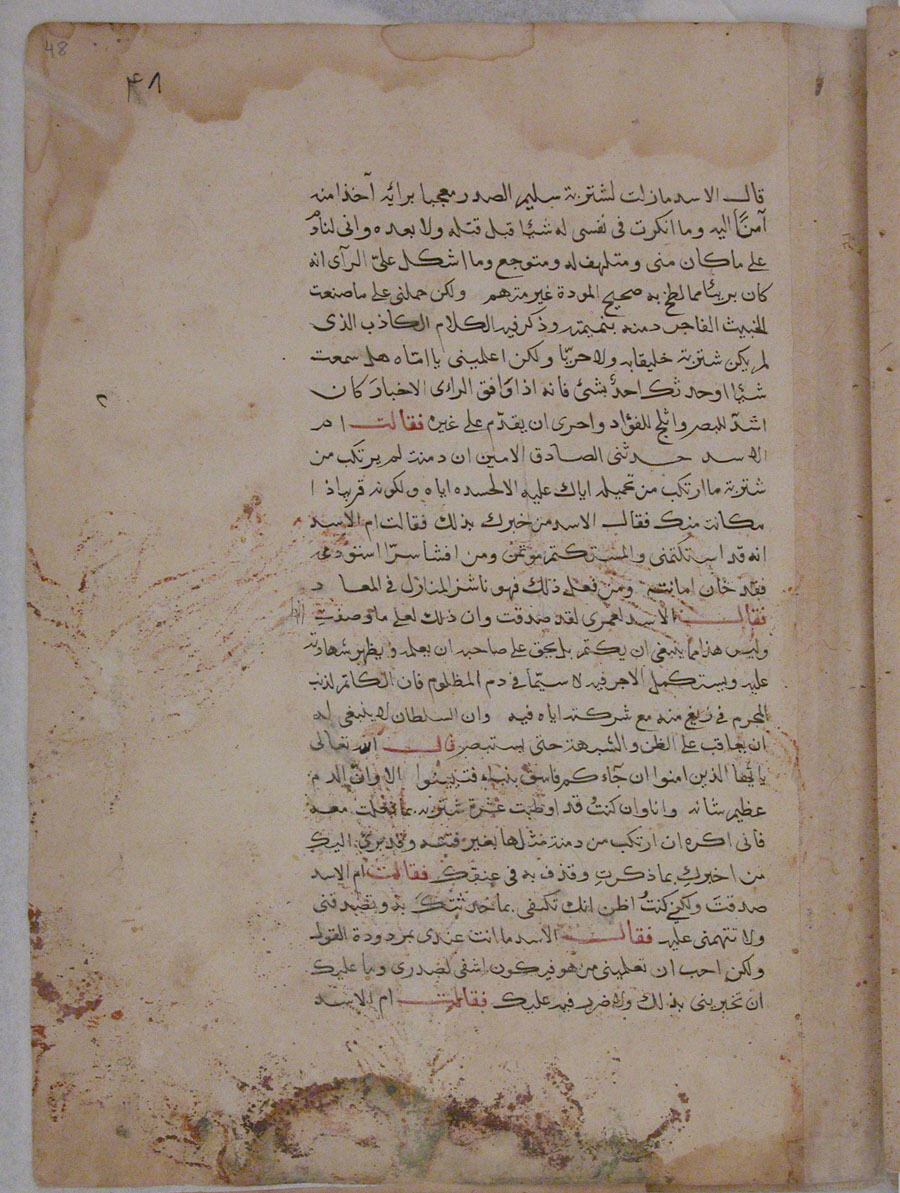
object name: folio from an illustrated manuscript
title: Page of Calligraphy from a Kalila wa Dimna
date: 1526-1550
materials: ink, paper, watercolor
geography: india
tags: arabic,calligraphy